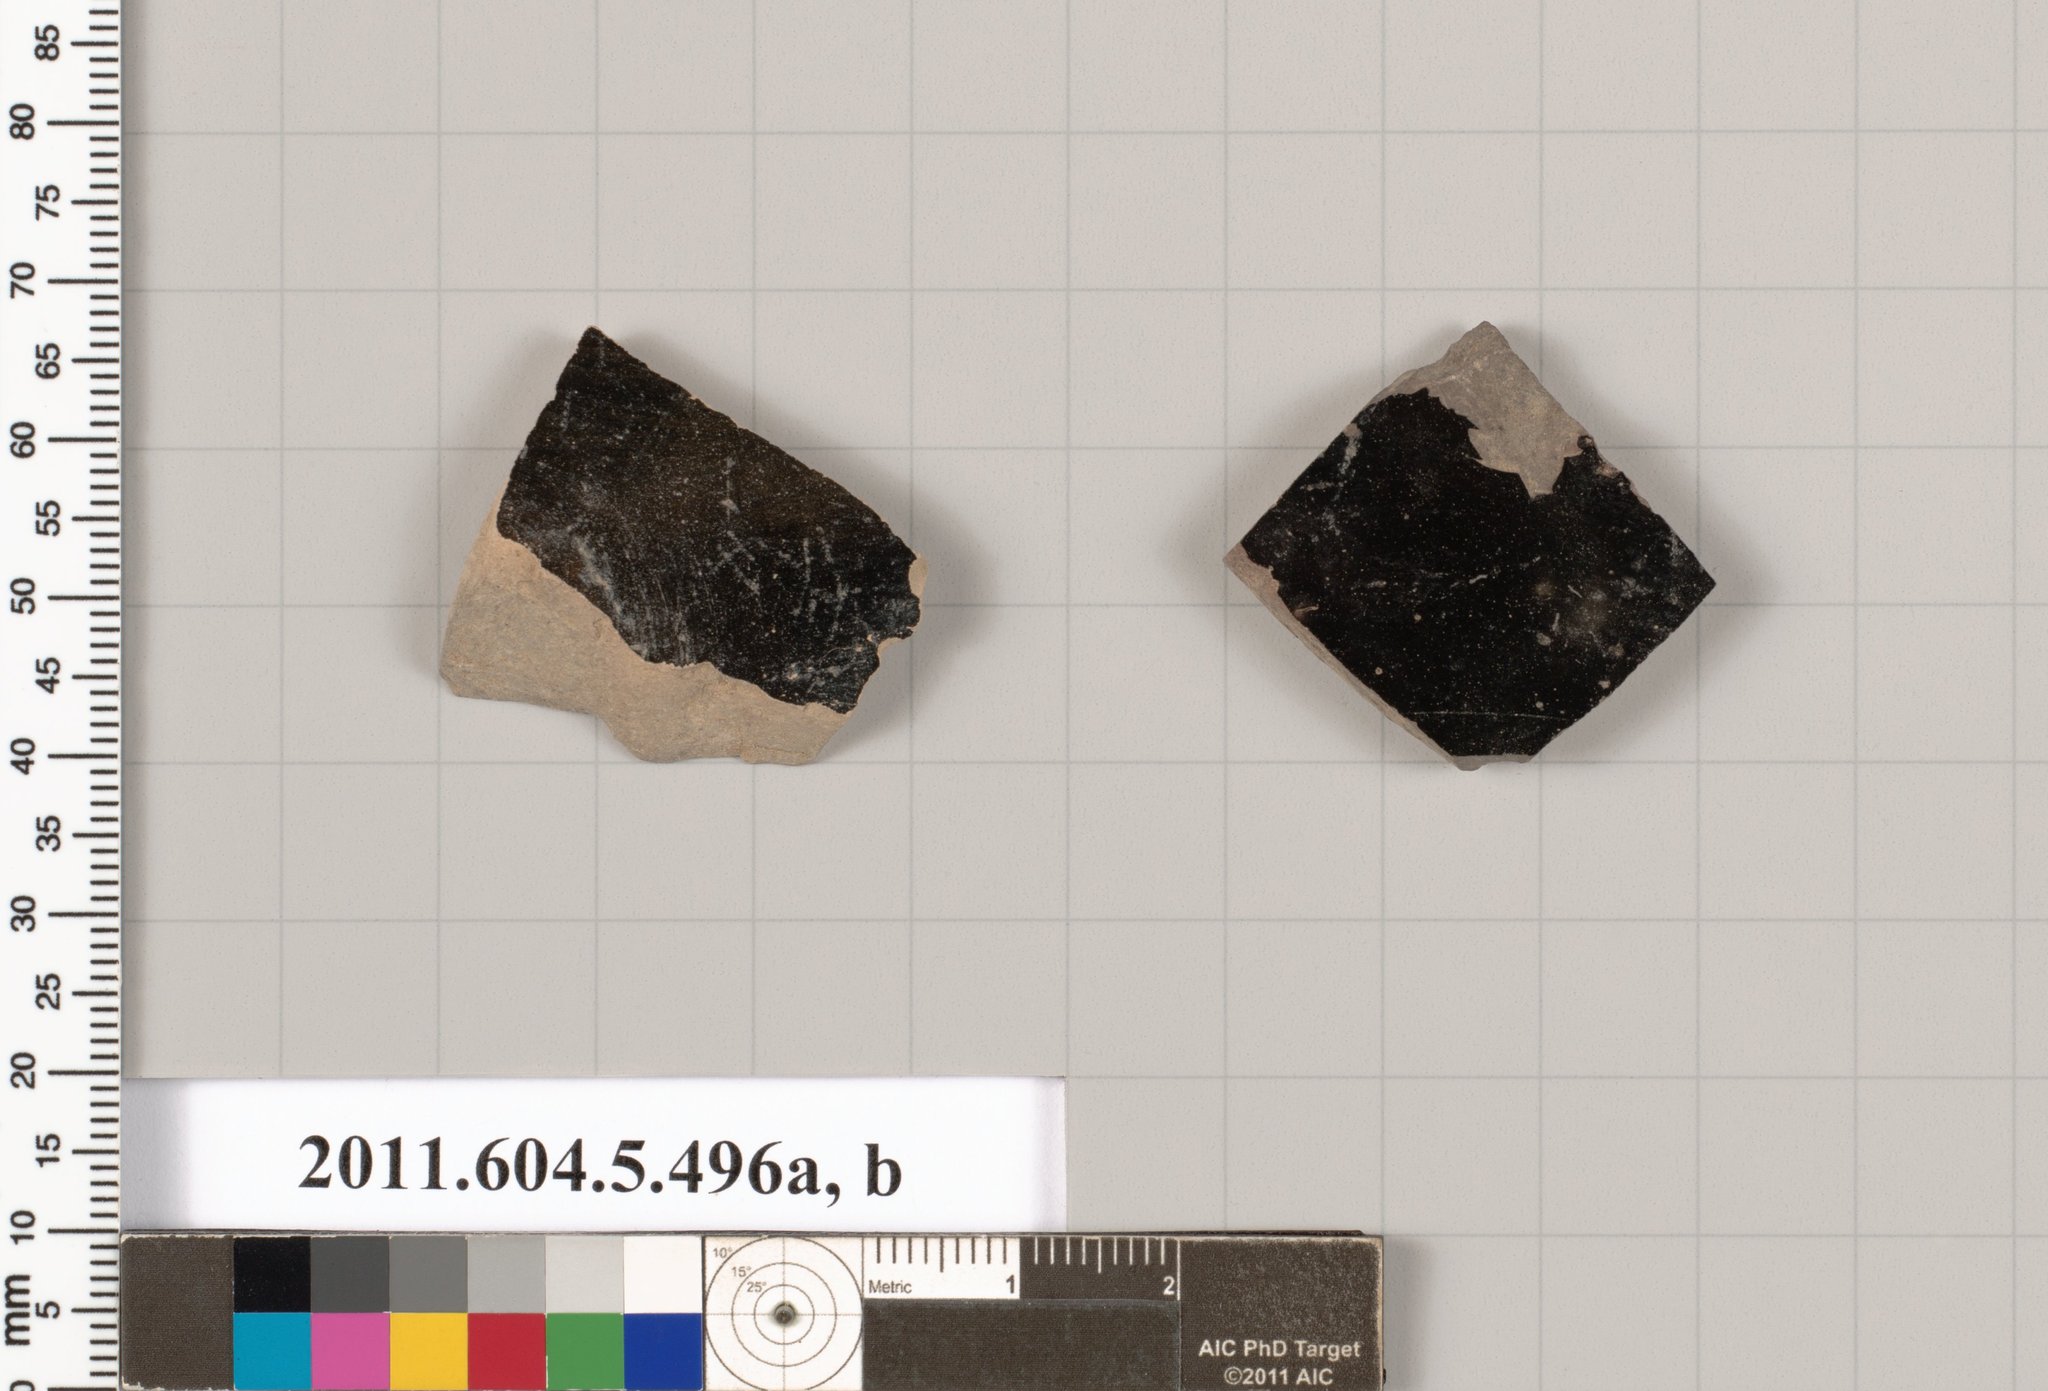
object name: kylix fragment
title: Terracotta fragments of a kylix (drinking cup)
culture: greek, attic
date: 600-401 BCE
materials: terracotta